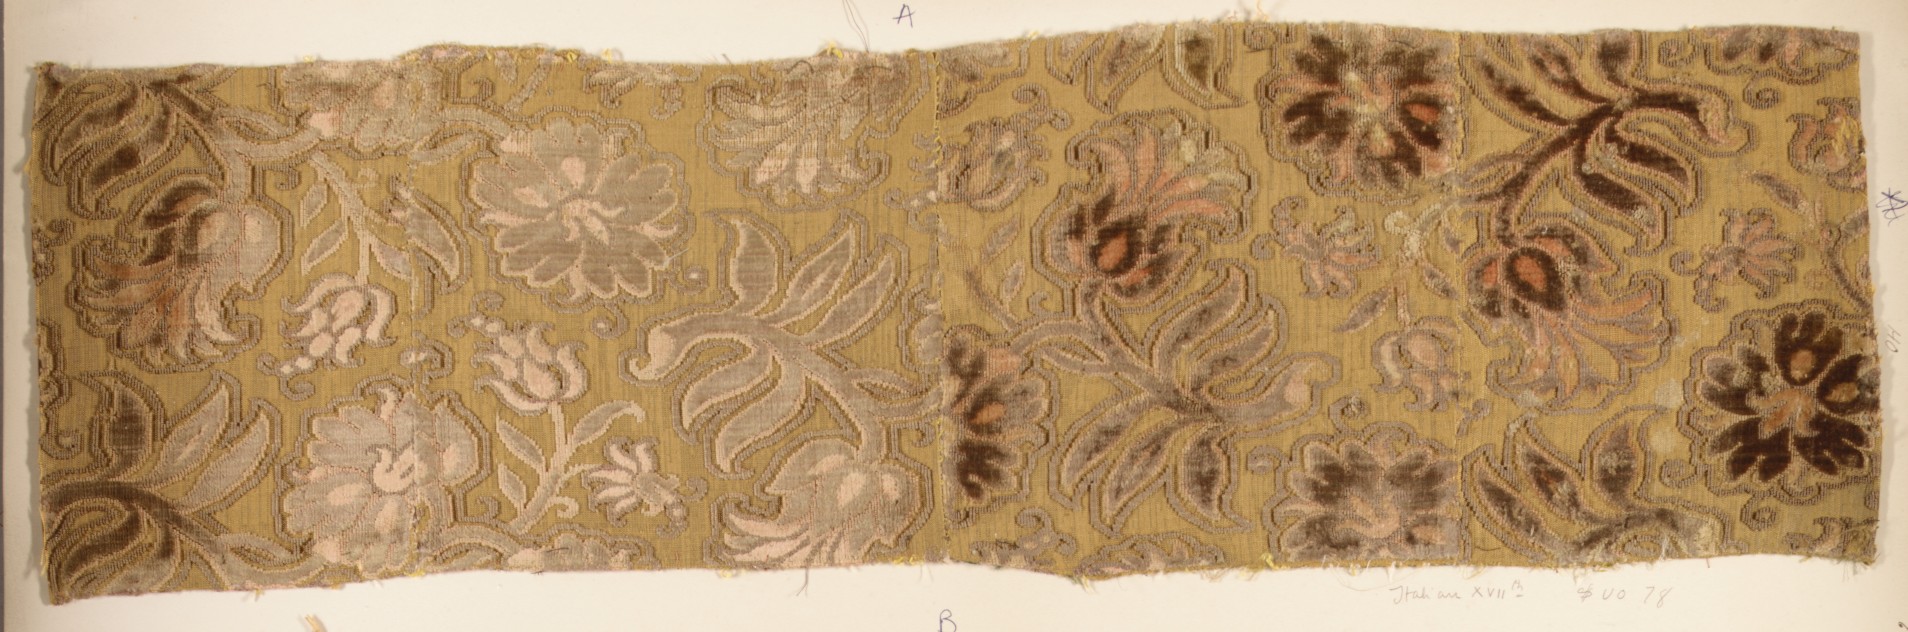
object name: fragment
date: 1601-1700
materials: metal thread, silk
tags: flowers,leaves